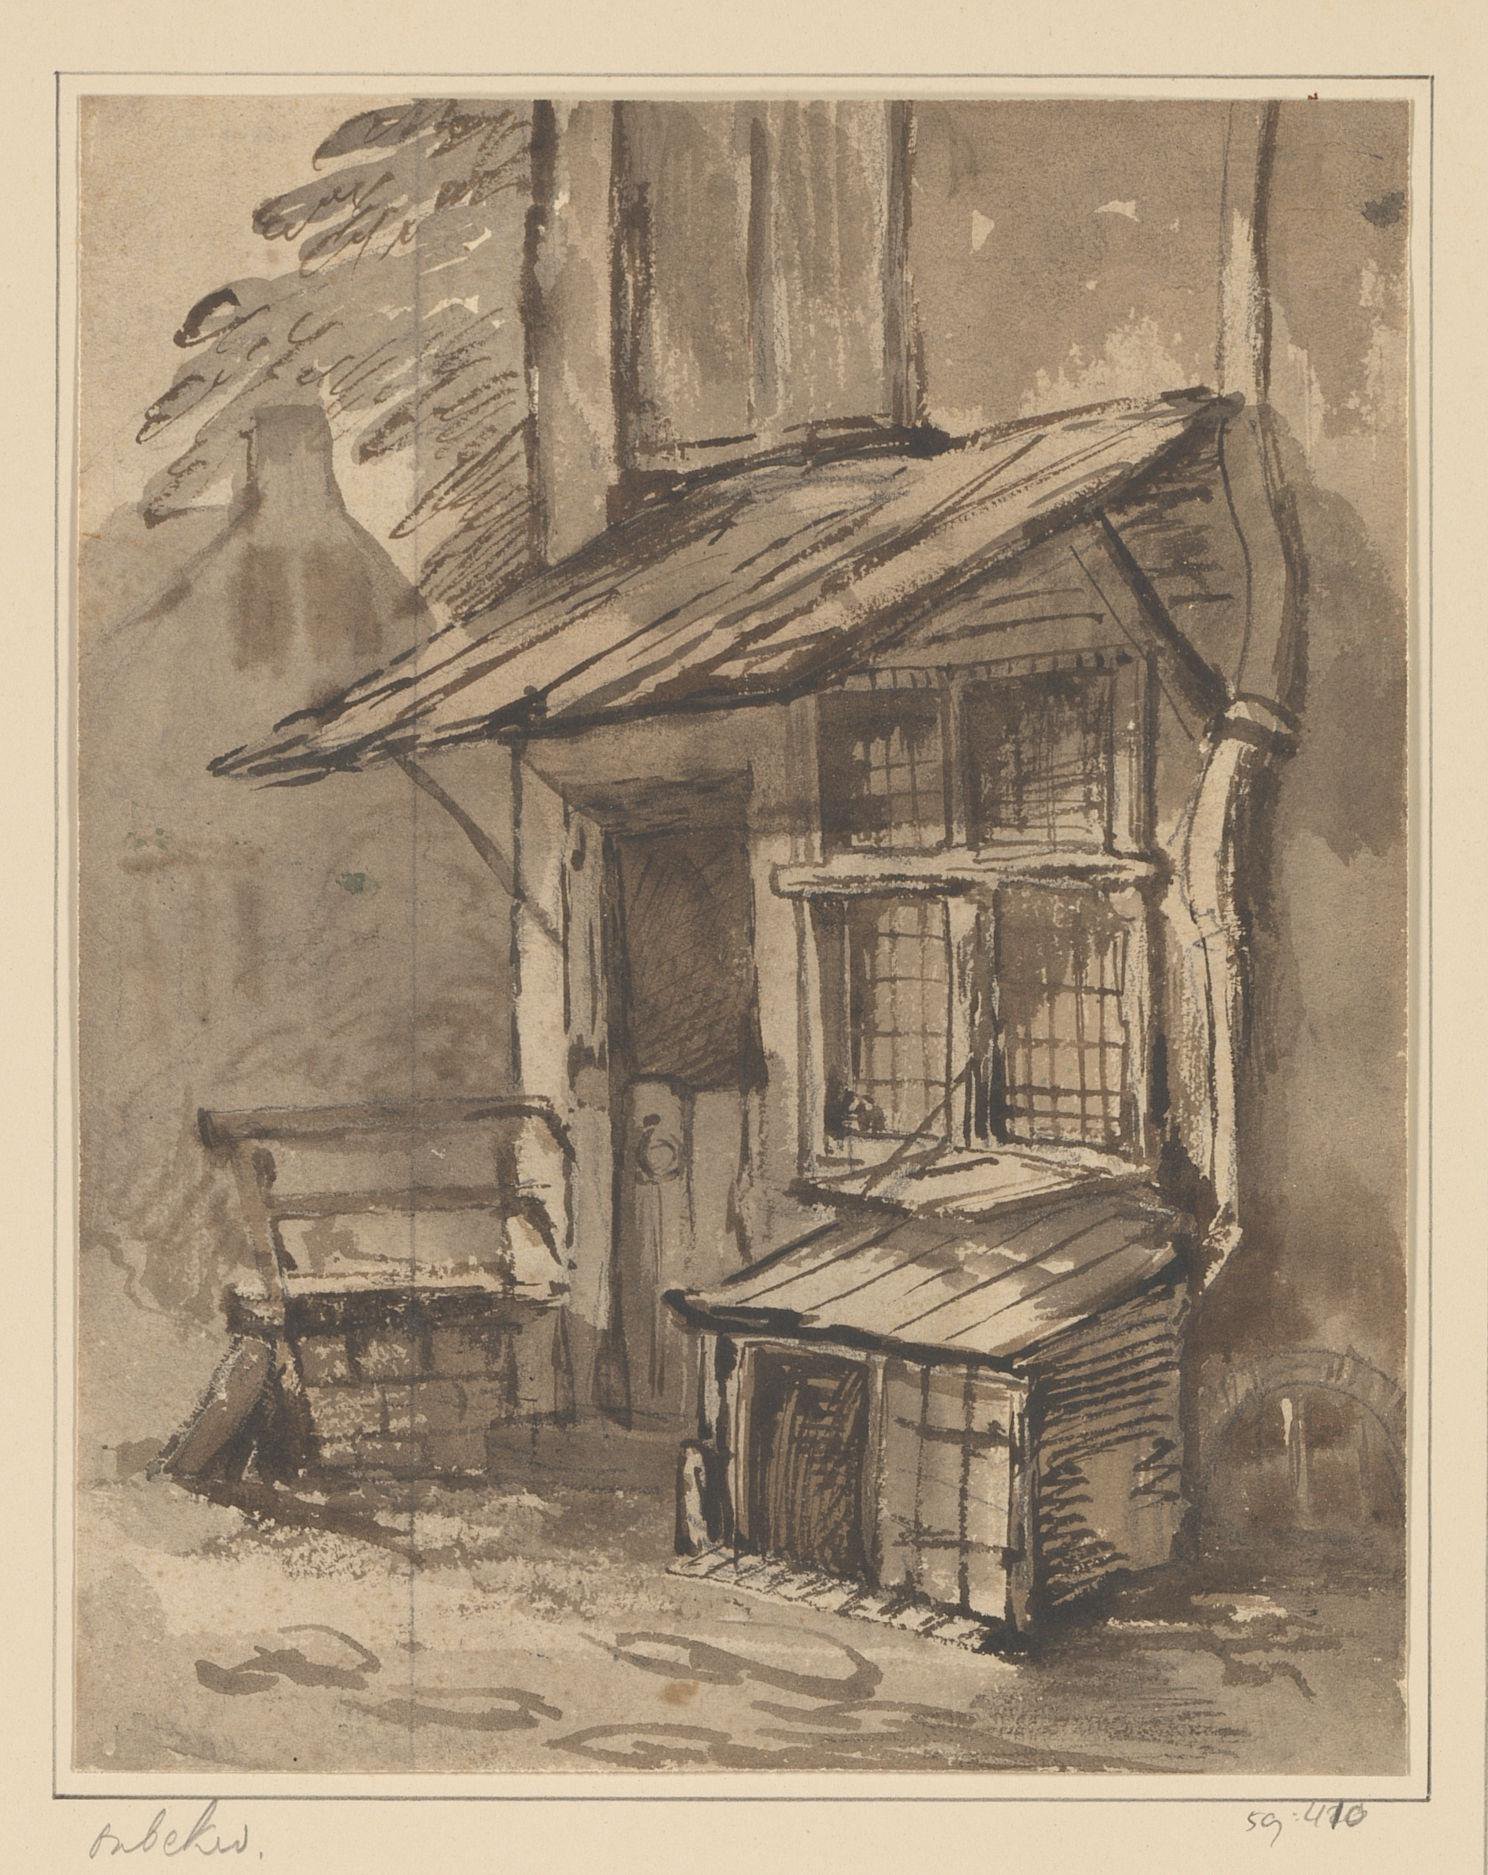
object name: drawing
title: Gevel van een woning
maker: johannes bosboom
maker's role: draughtsman, painter, print maker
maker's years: 1817-1891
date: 1827-1891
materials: ink, paper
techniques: brush, pen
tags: exterior ~ representation of a building